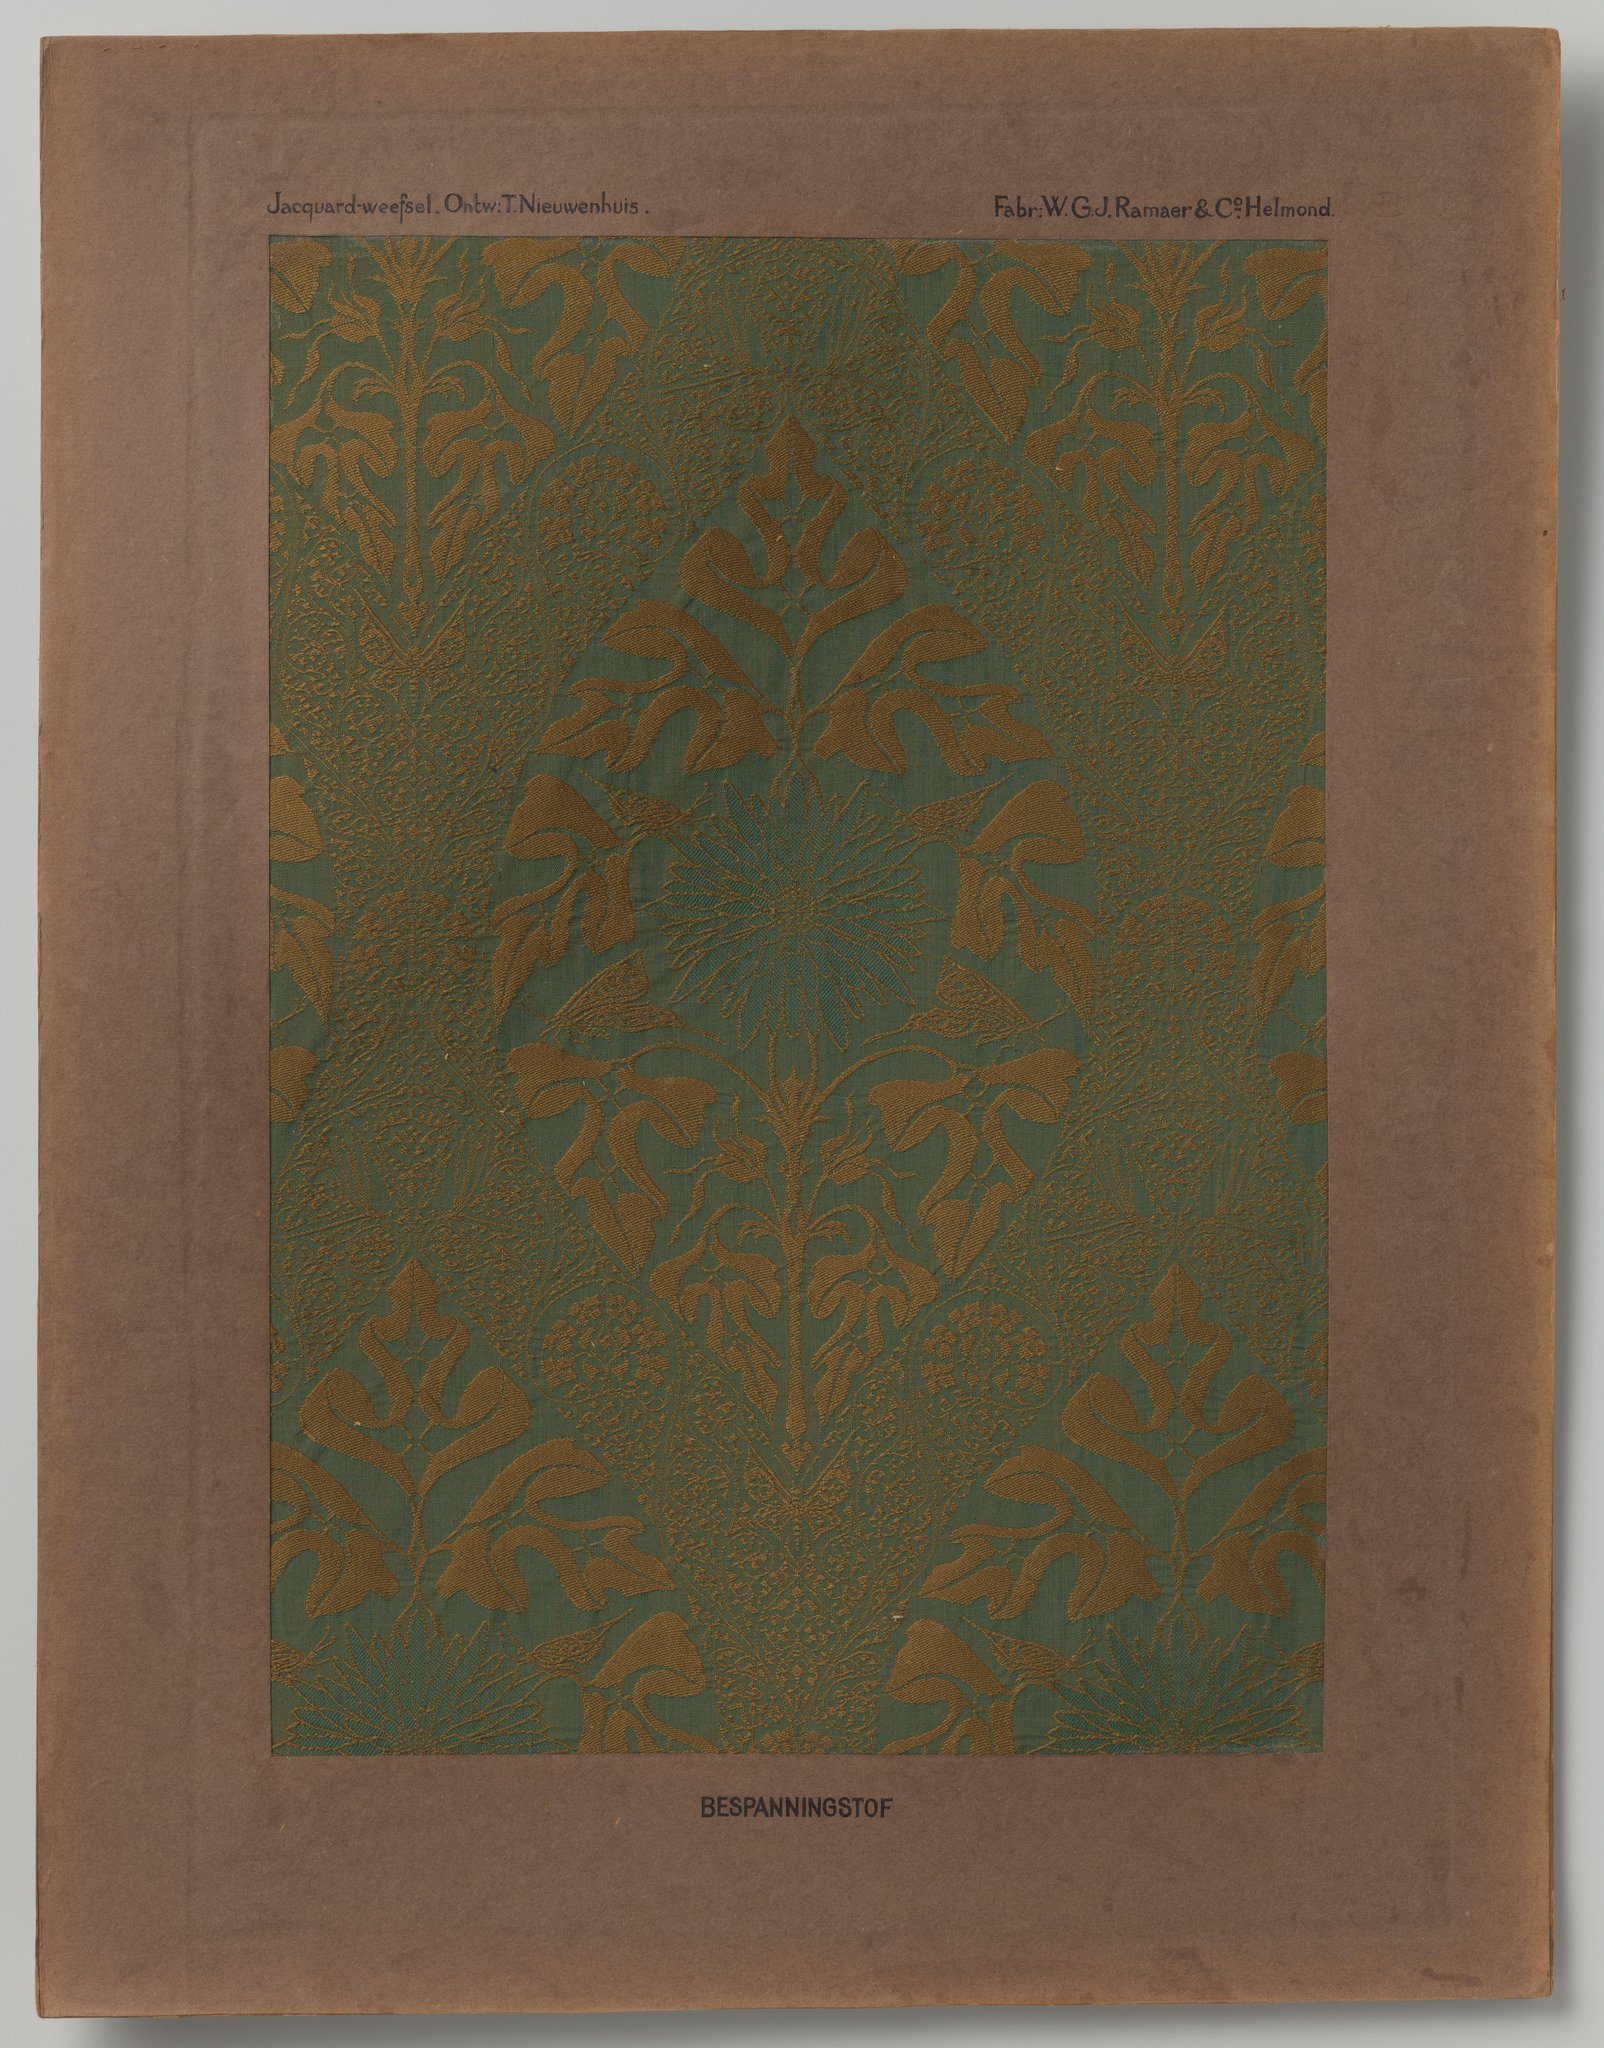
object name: sample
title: Staal bespanningsstof naar ontwerp van Theo Nieuwenhuis in passe-partout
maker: theo nieuwenhuis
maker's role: designer, draughtsman, print maker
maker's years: 1866-1951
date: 1910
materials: cardboard, cotton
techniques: jacquard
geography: helmond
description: Staal bespanningsstof van jacquardgeweven katoen naar ontwerp van Theo Nieuwenhuis, in origineel passe-partout. Het patroon bestaat uit een aster, bladeren en vlinders in een spitsovaal, omringd door brede banden met klein gestileerde blad-, bloemvormen, vlinders en libelles. Olijfgroene inslag op donkergroene ketting.